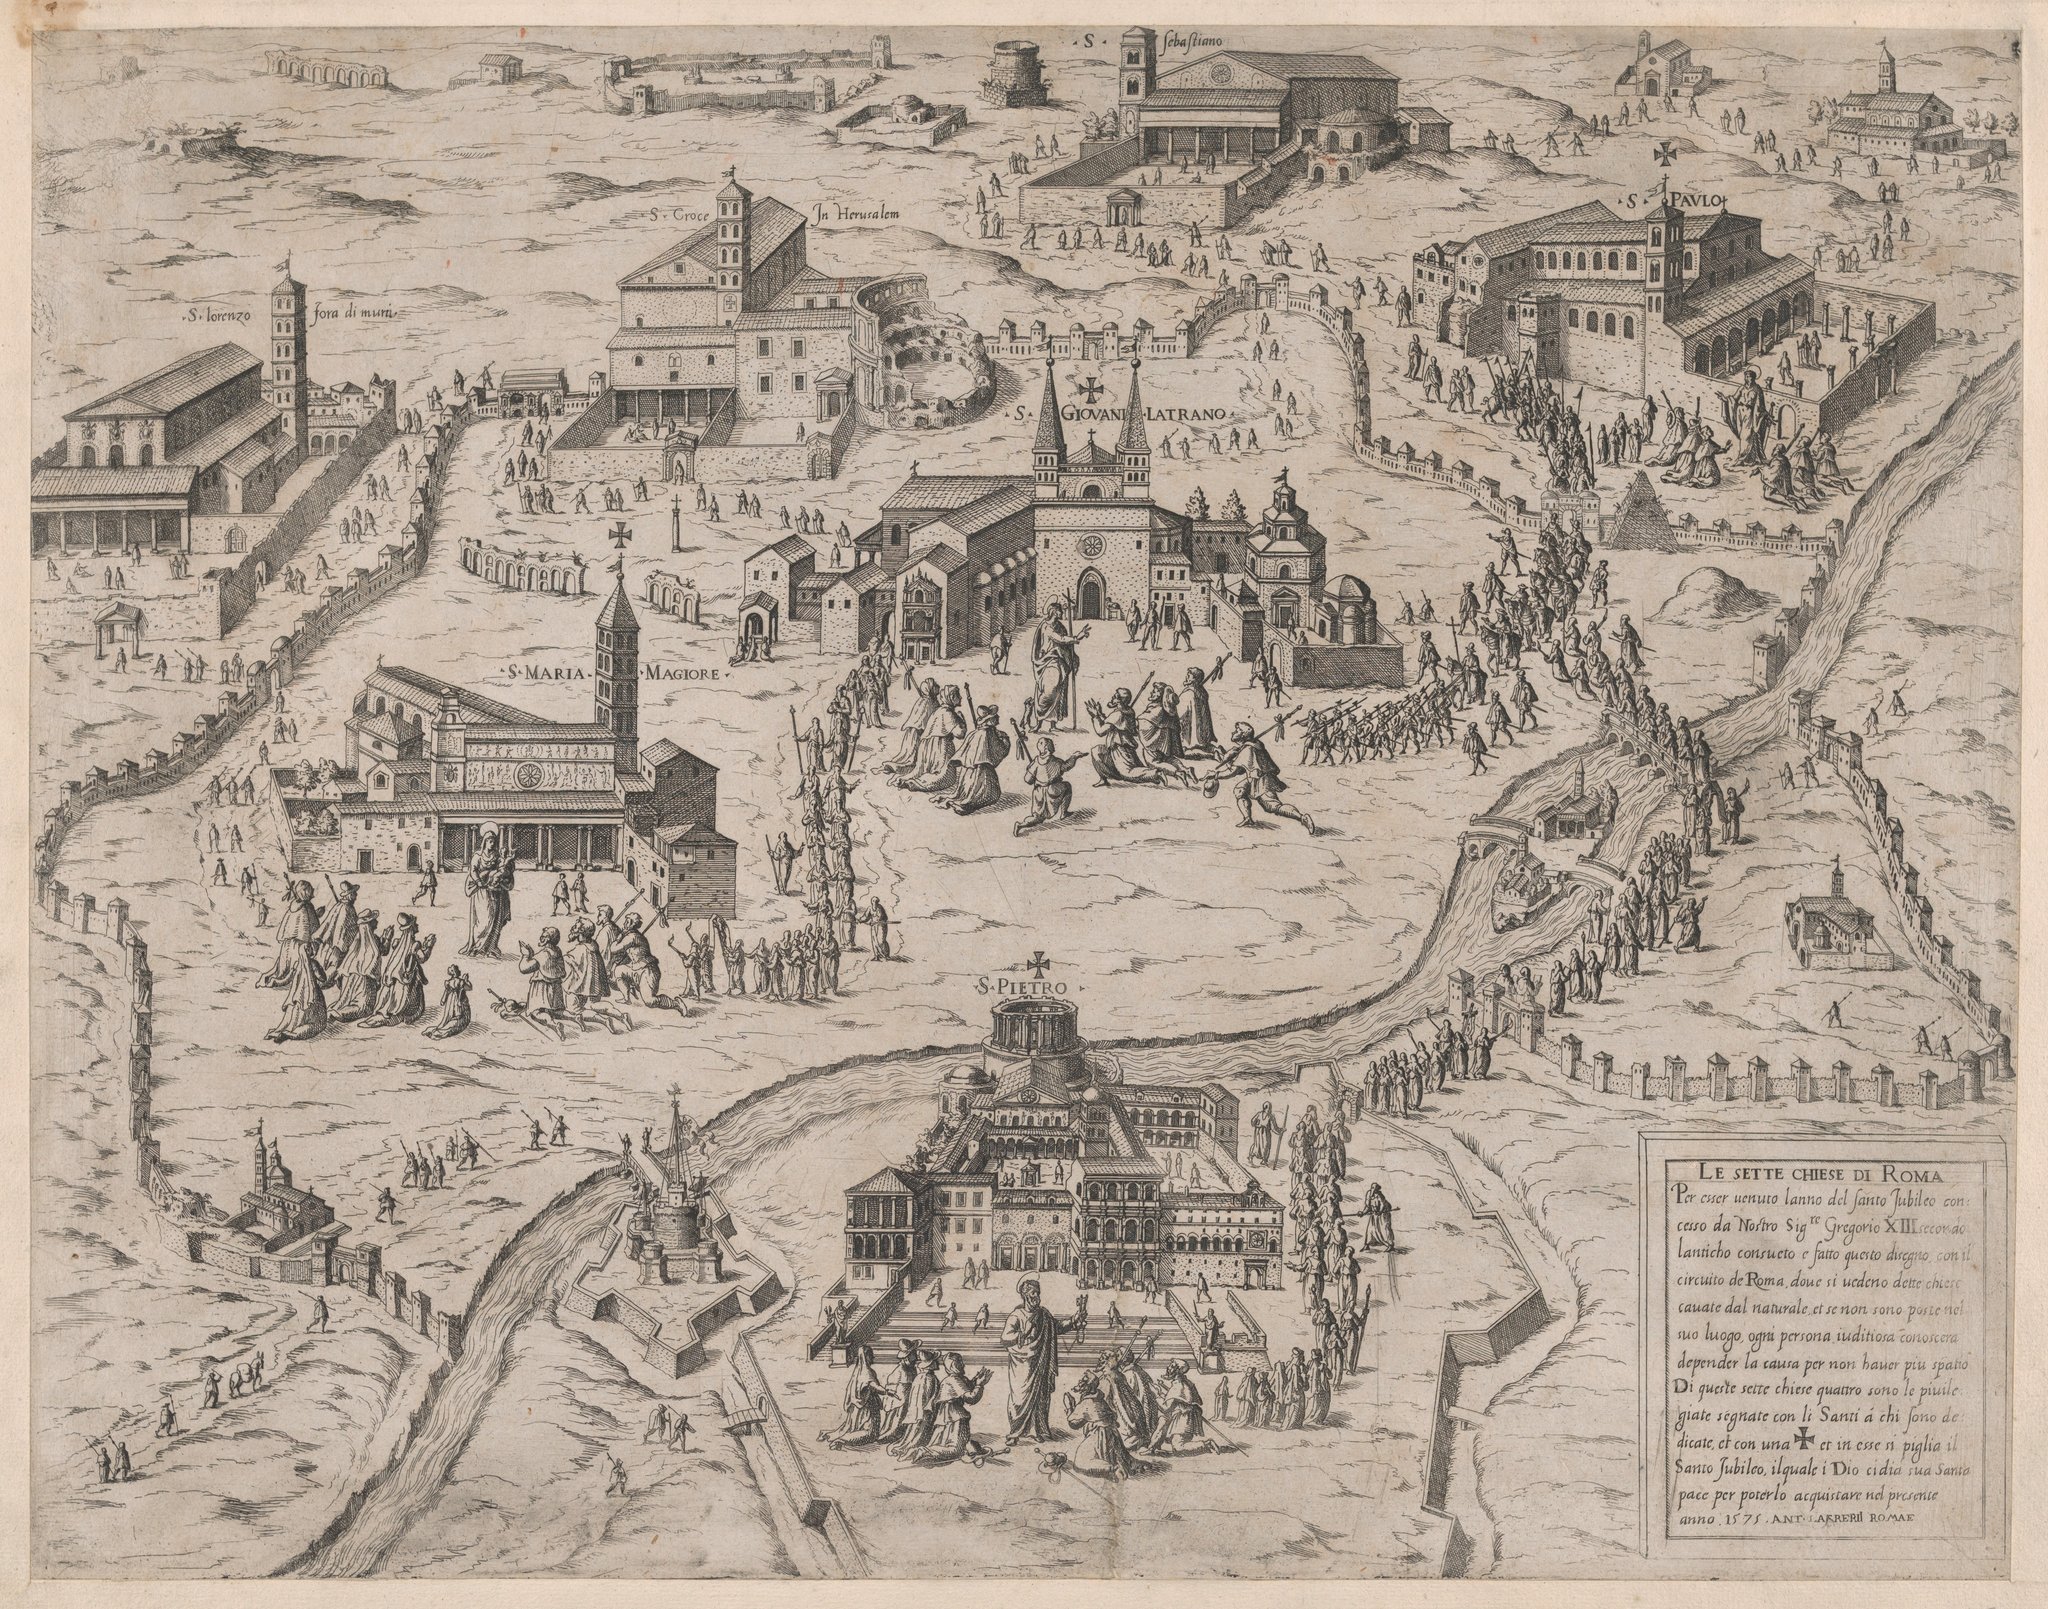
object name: print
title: The Seven Churches of Rome (Le Sette Chiese di Roma), from "Speculum Romanae Magnificentiae"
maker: giovanni ambrogio brambilla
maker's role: artist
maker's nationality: italian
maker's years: 1575-1599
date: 1575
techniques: engraving, etching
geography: rome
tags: human figures,cities,churches,rome